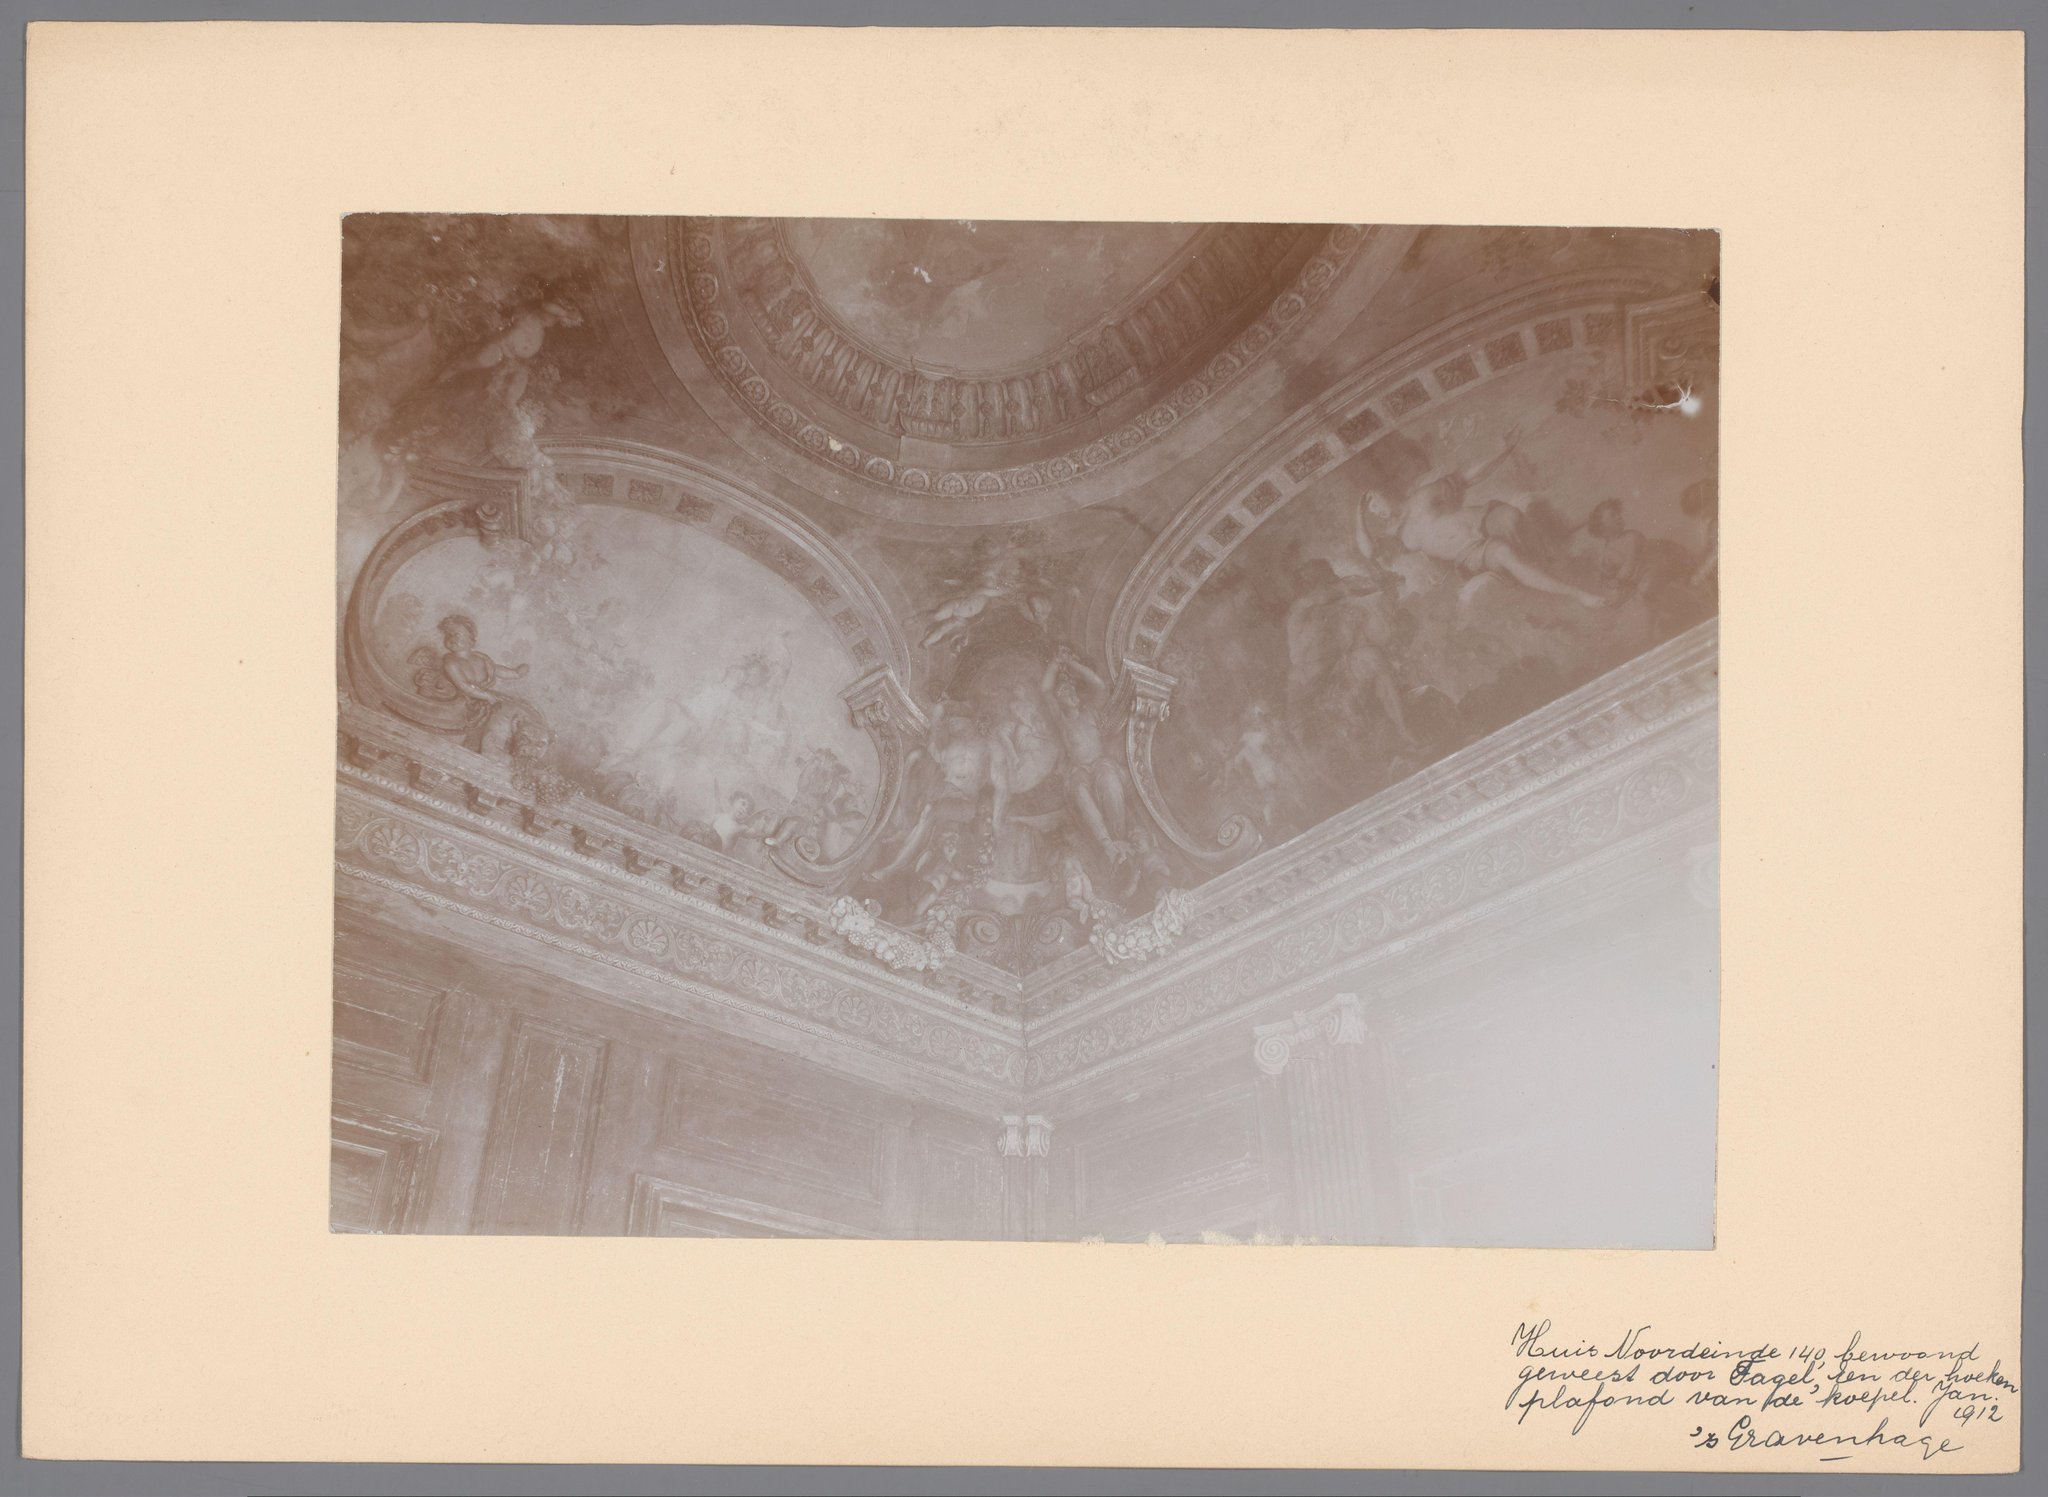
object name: photograph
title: Geschilderd plafond in Noordeinde 140 te Den Haag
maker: anoniem (monumentenzorg)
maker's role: fotograaf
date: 1912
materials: cardboard, photographic support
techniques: collodion silver print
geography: noordeinde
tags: (decorated) ceiling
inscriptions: collector's mark: ‘R:MUS.’ Lugt 2228, annotation: ‘Huis Noordeinde 140, bewoond geweest door Fagel, een der hoeken plafond van de koepel. Jan. 1912/ 's Gravenhage’